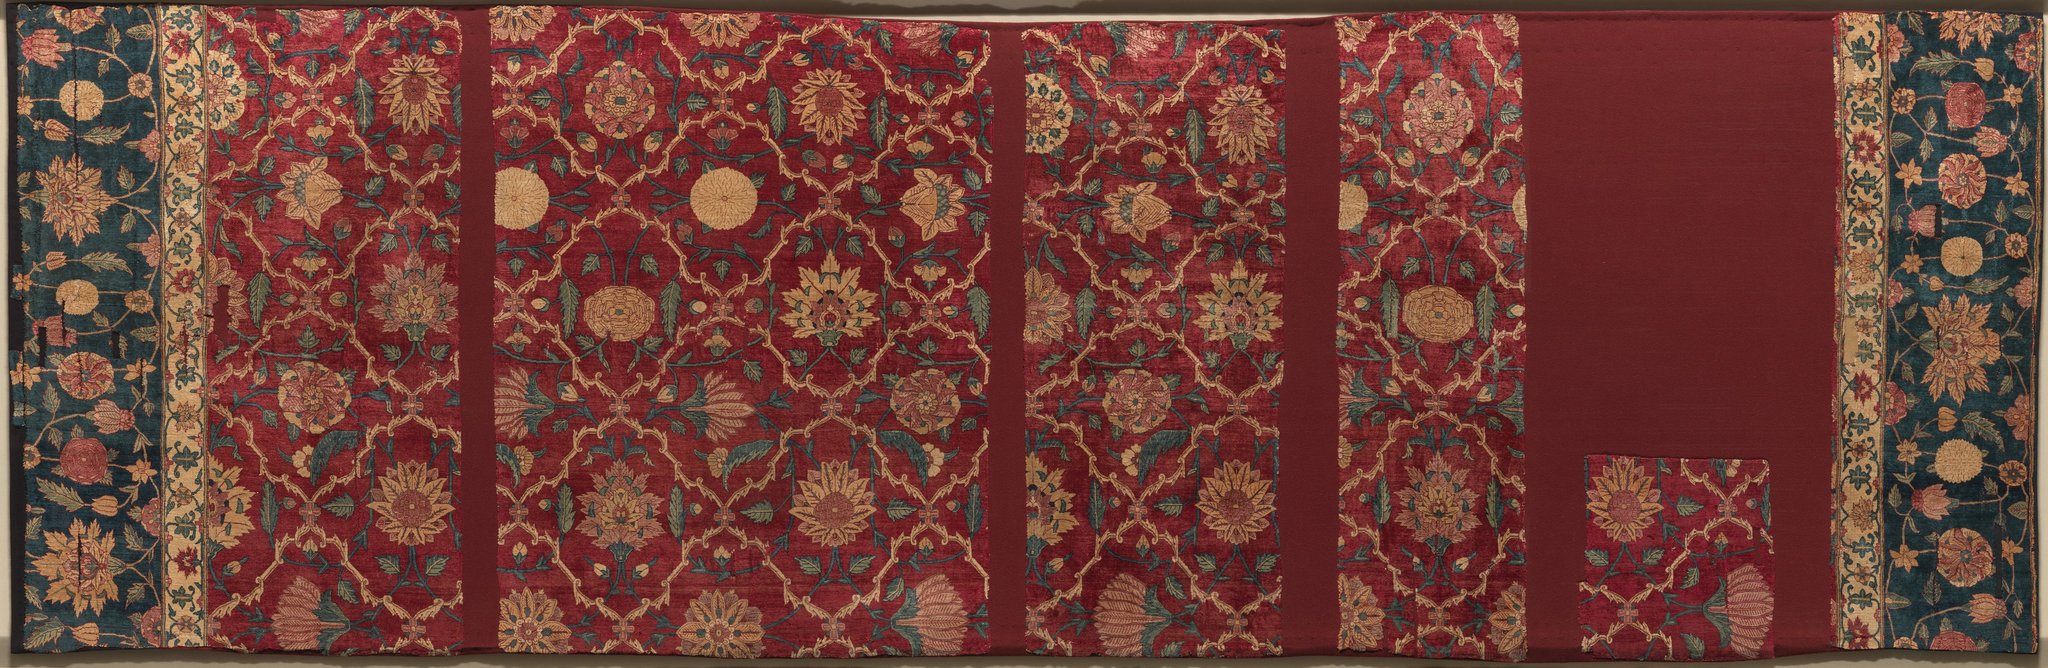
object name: carpet fragment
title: Fragments of a Trellis Pattern Carpet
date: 1650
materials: silk, wool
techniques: asymmetrically knotted pile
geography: india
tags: flowers